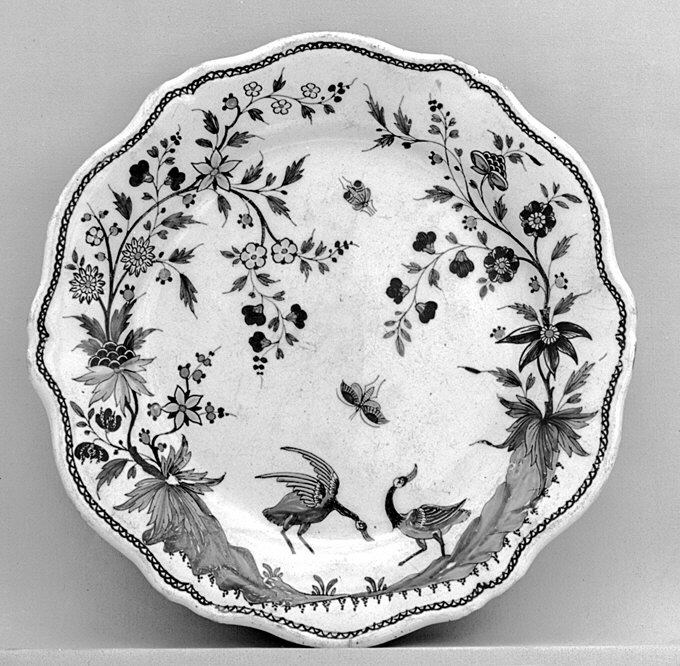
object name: plate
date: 1750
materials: faience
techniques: glazing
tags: birds,insects,flowers